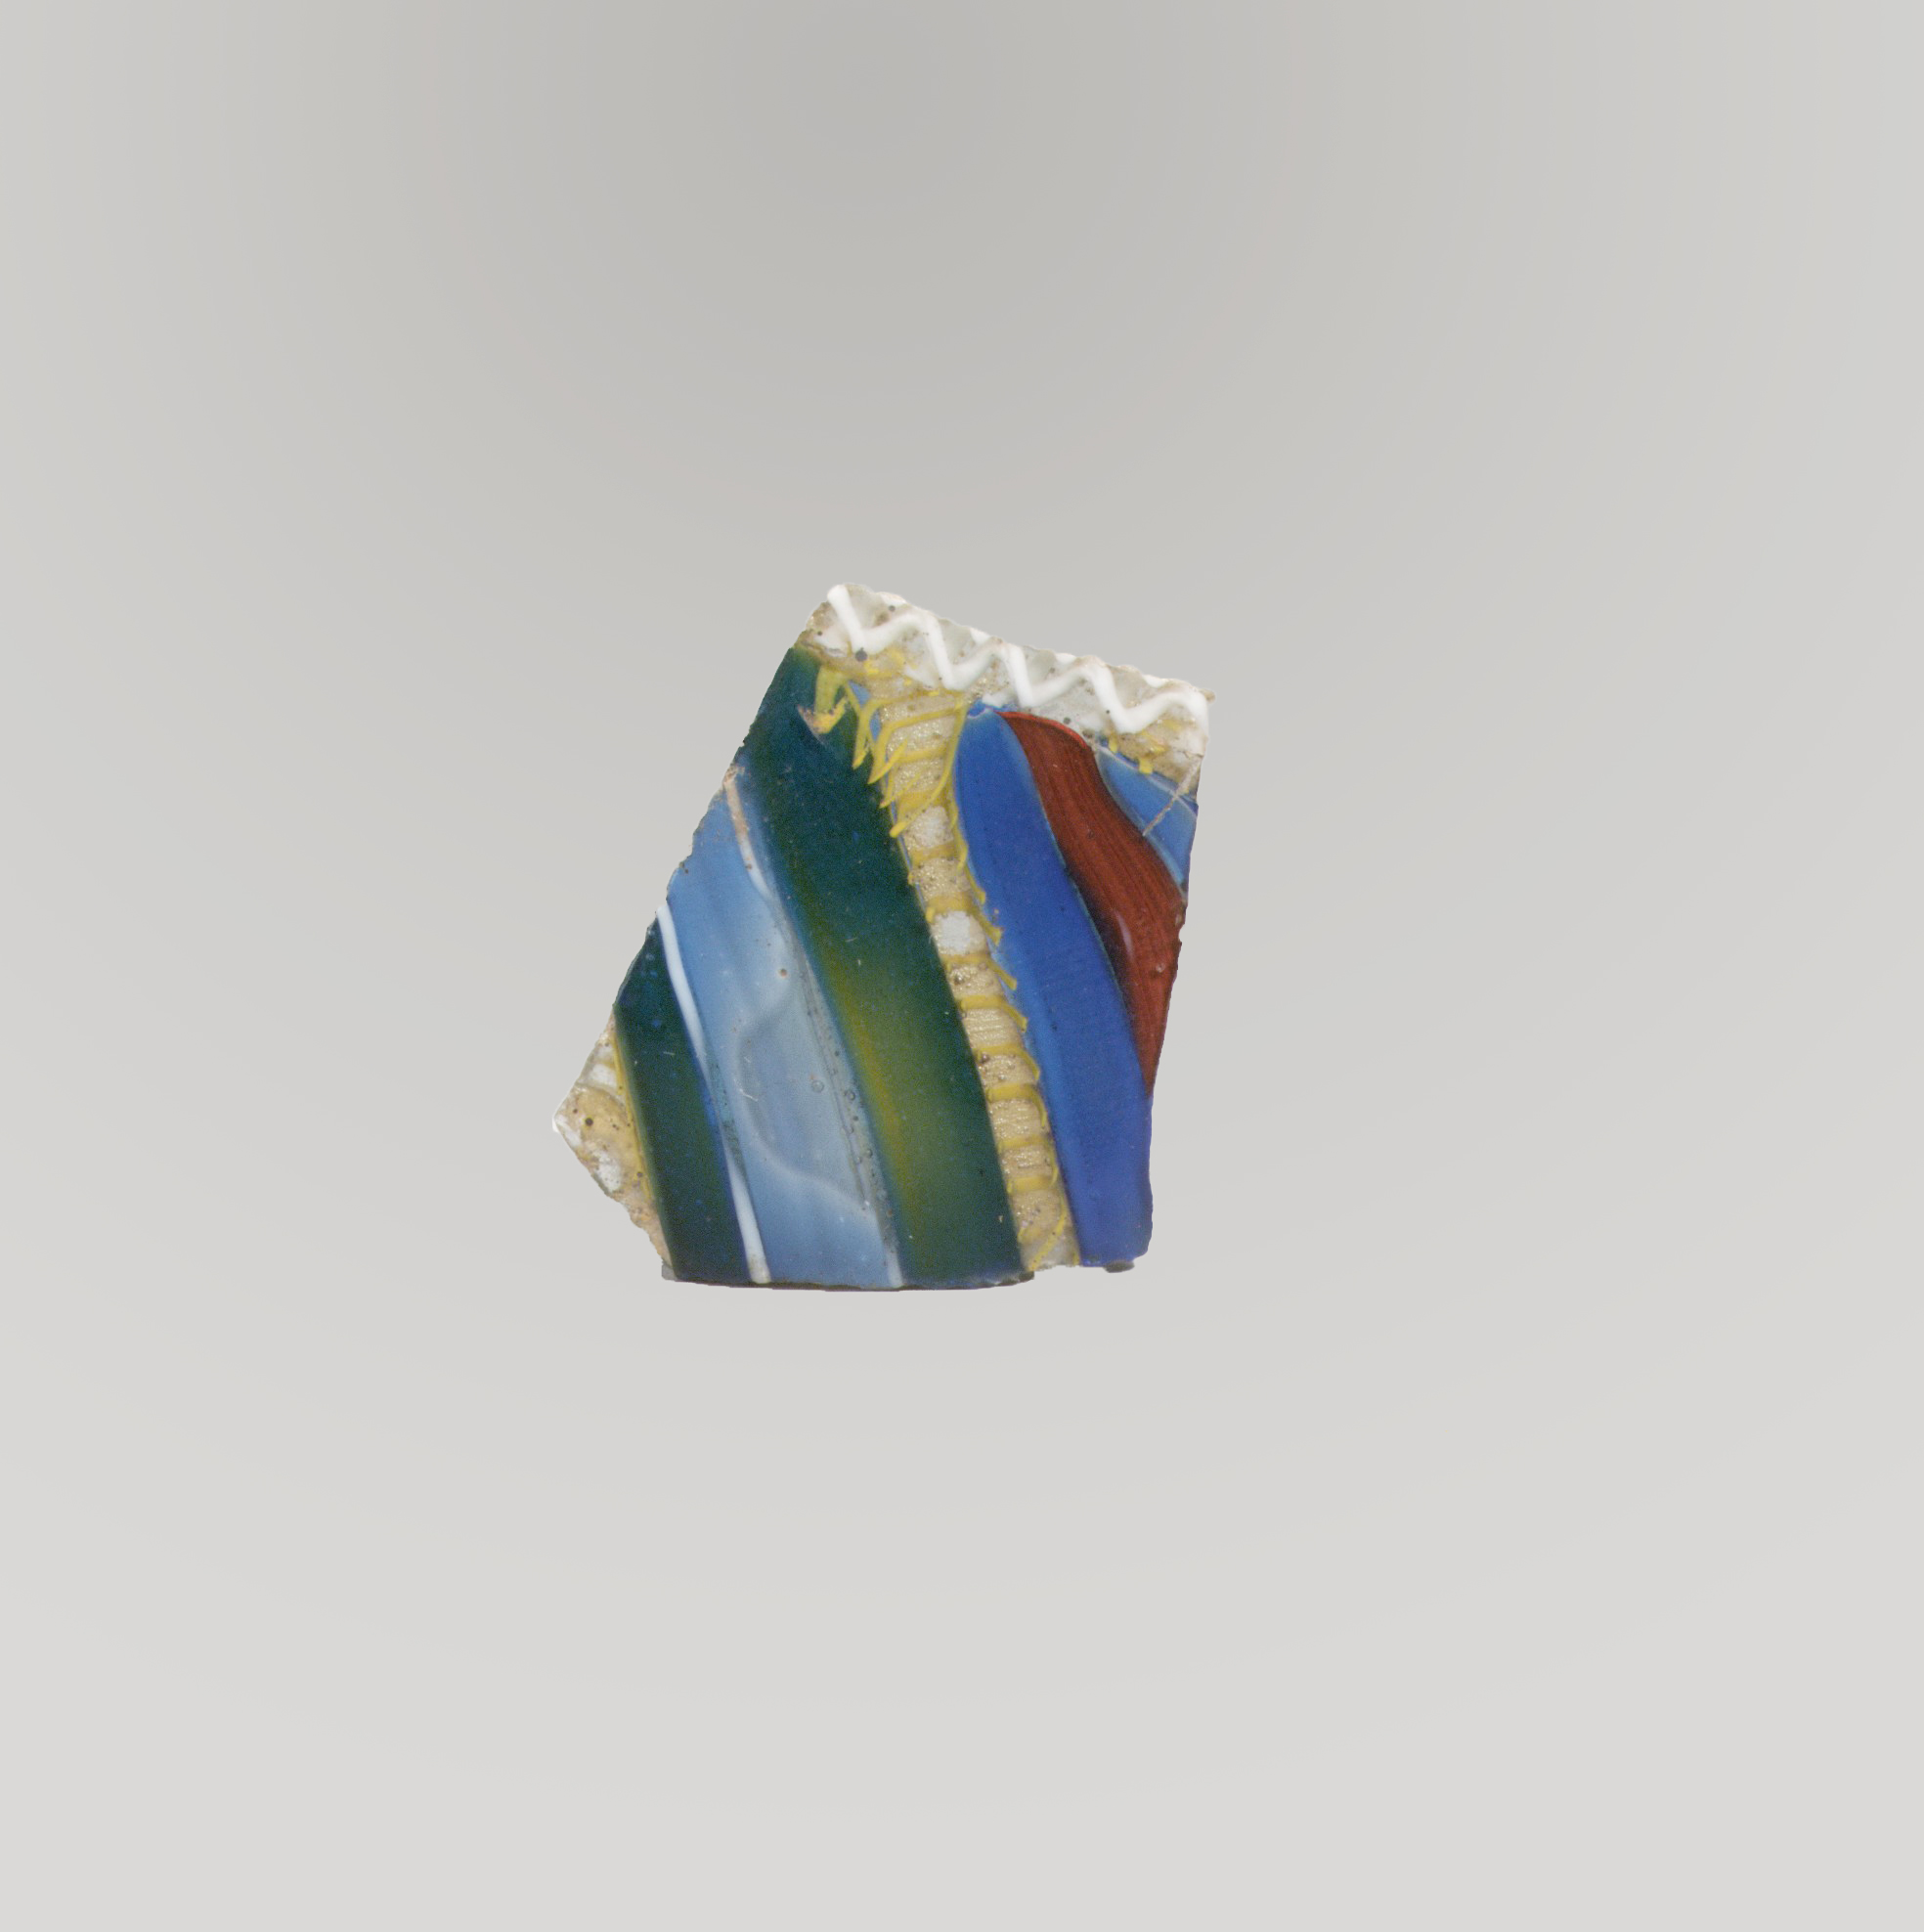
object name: fragment, striped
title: Glass striped mosaic bowl fragment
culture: roman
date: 34 BCE-33 CE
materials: glass